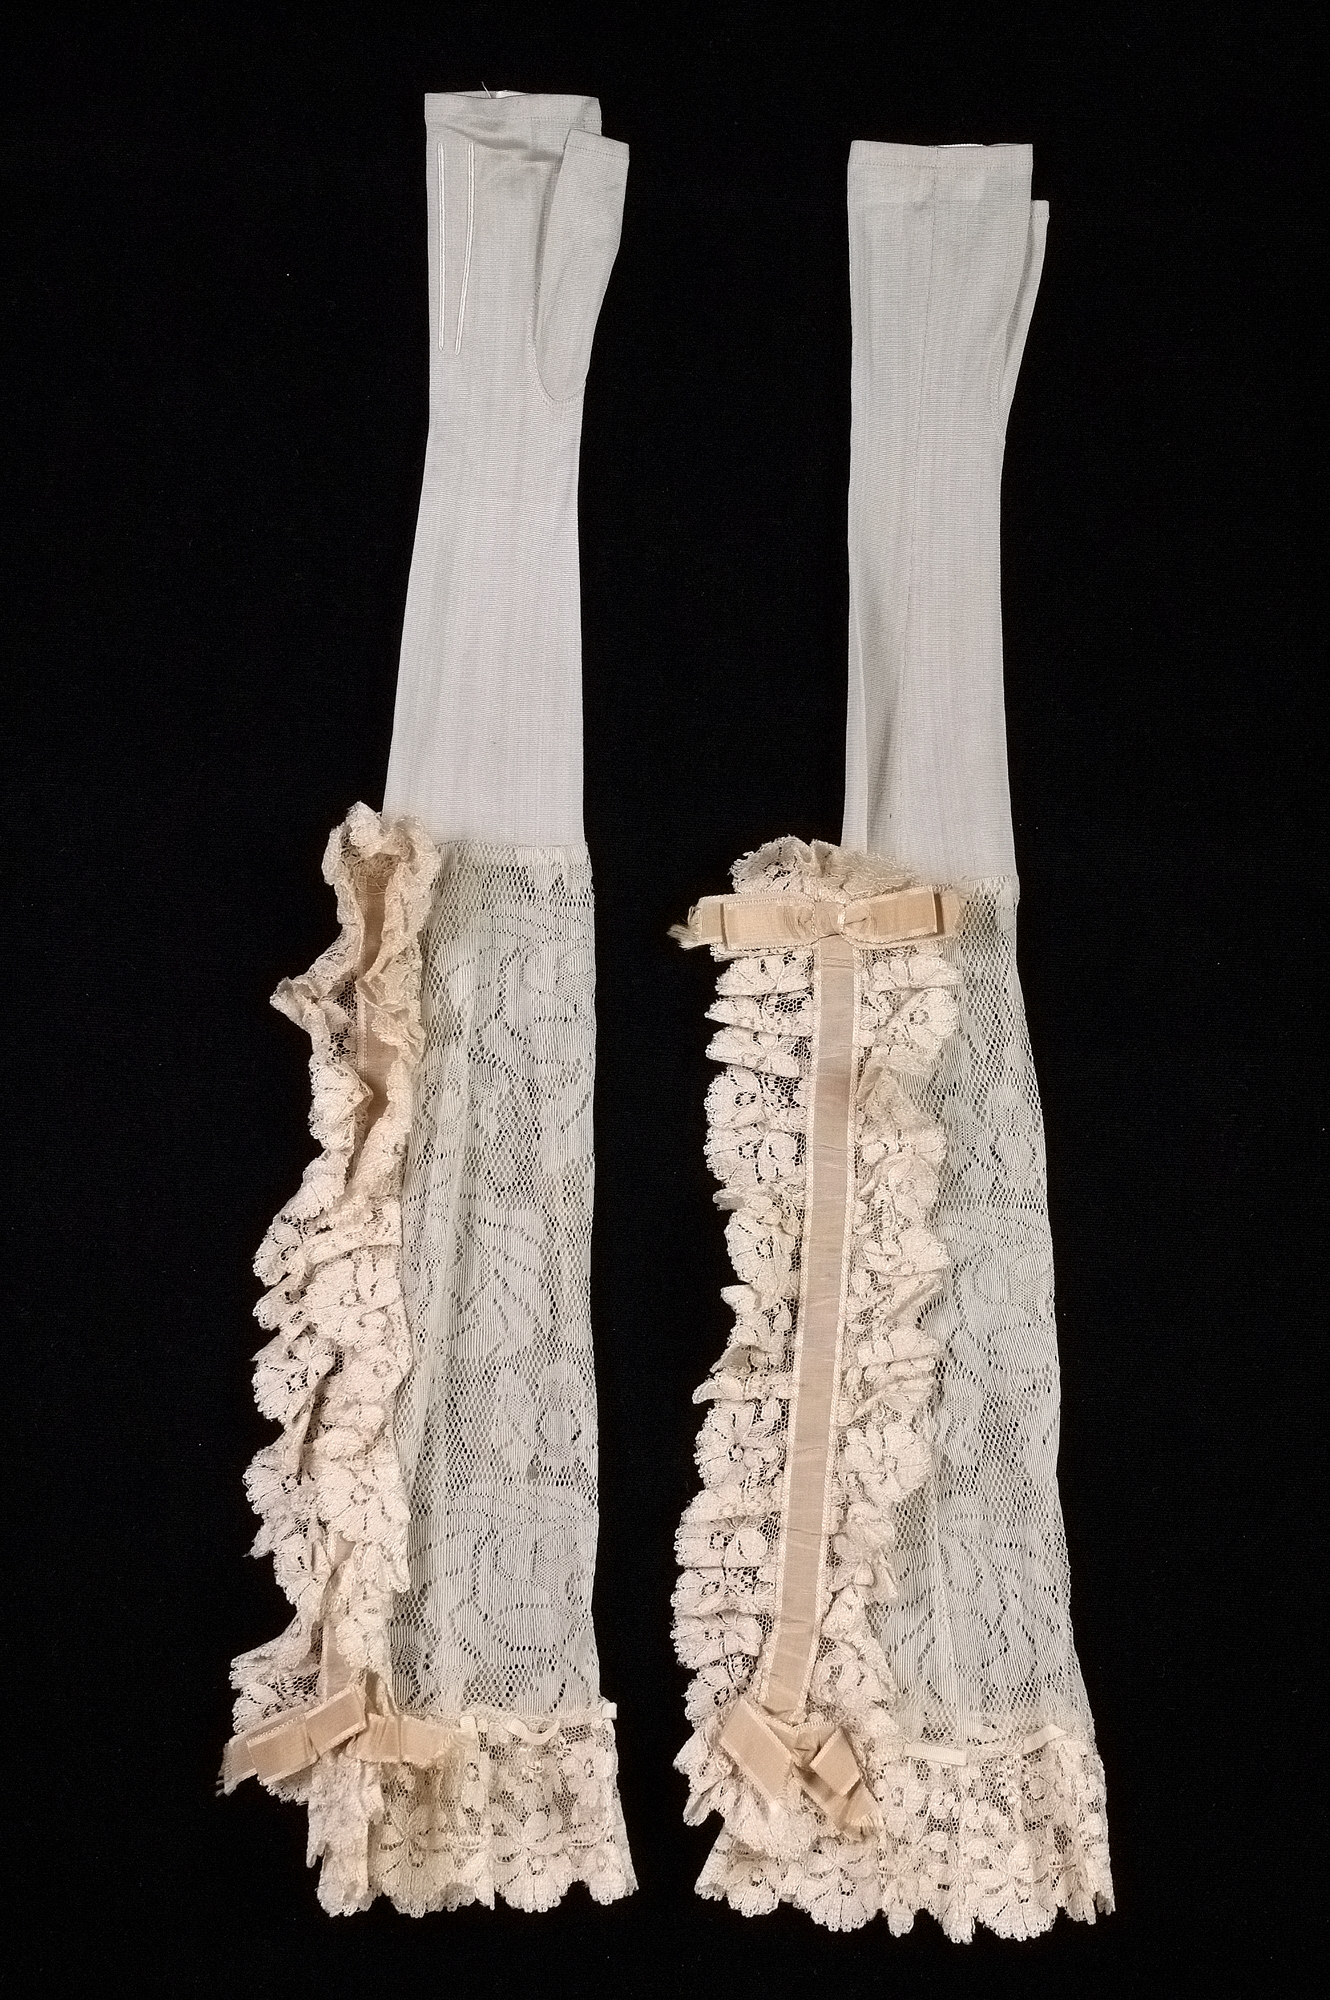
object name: evening mitt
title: Evening mitts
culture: american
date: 1880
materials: silk